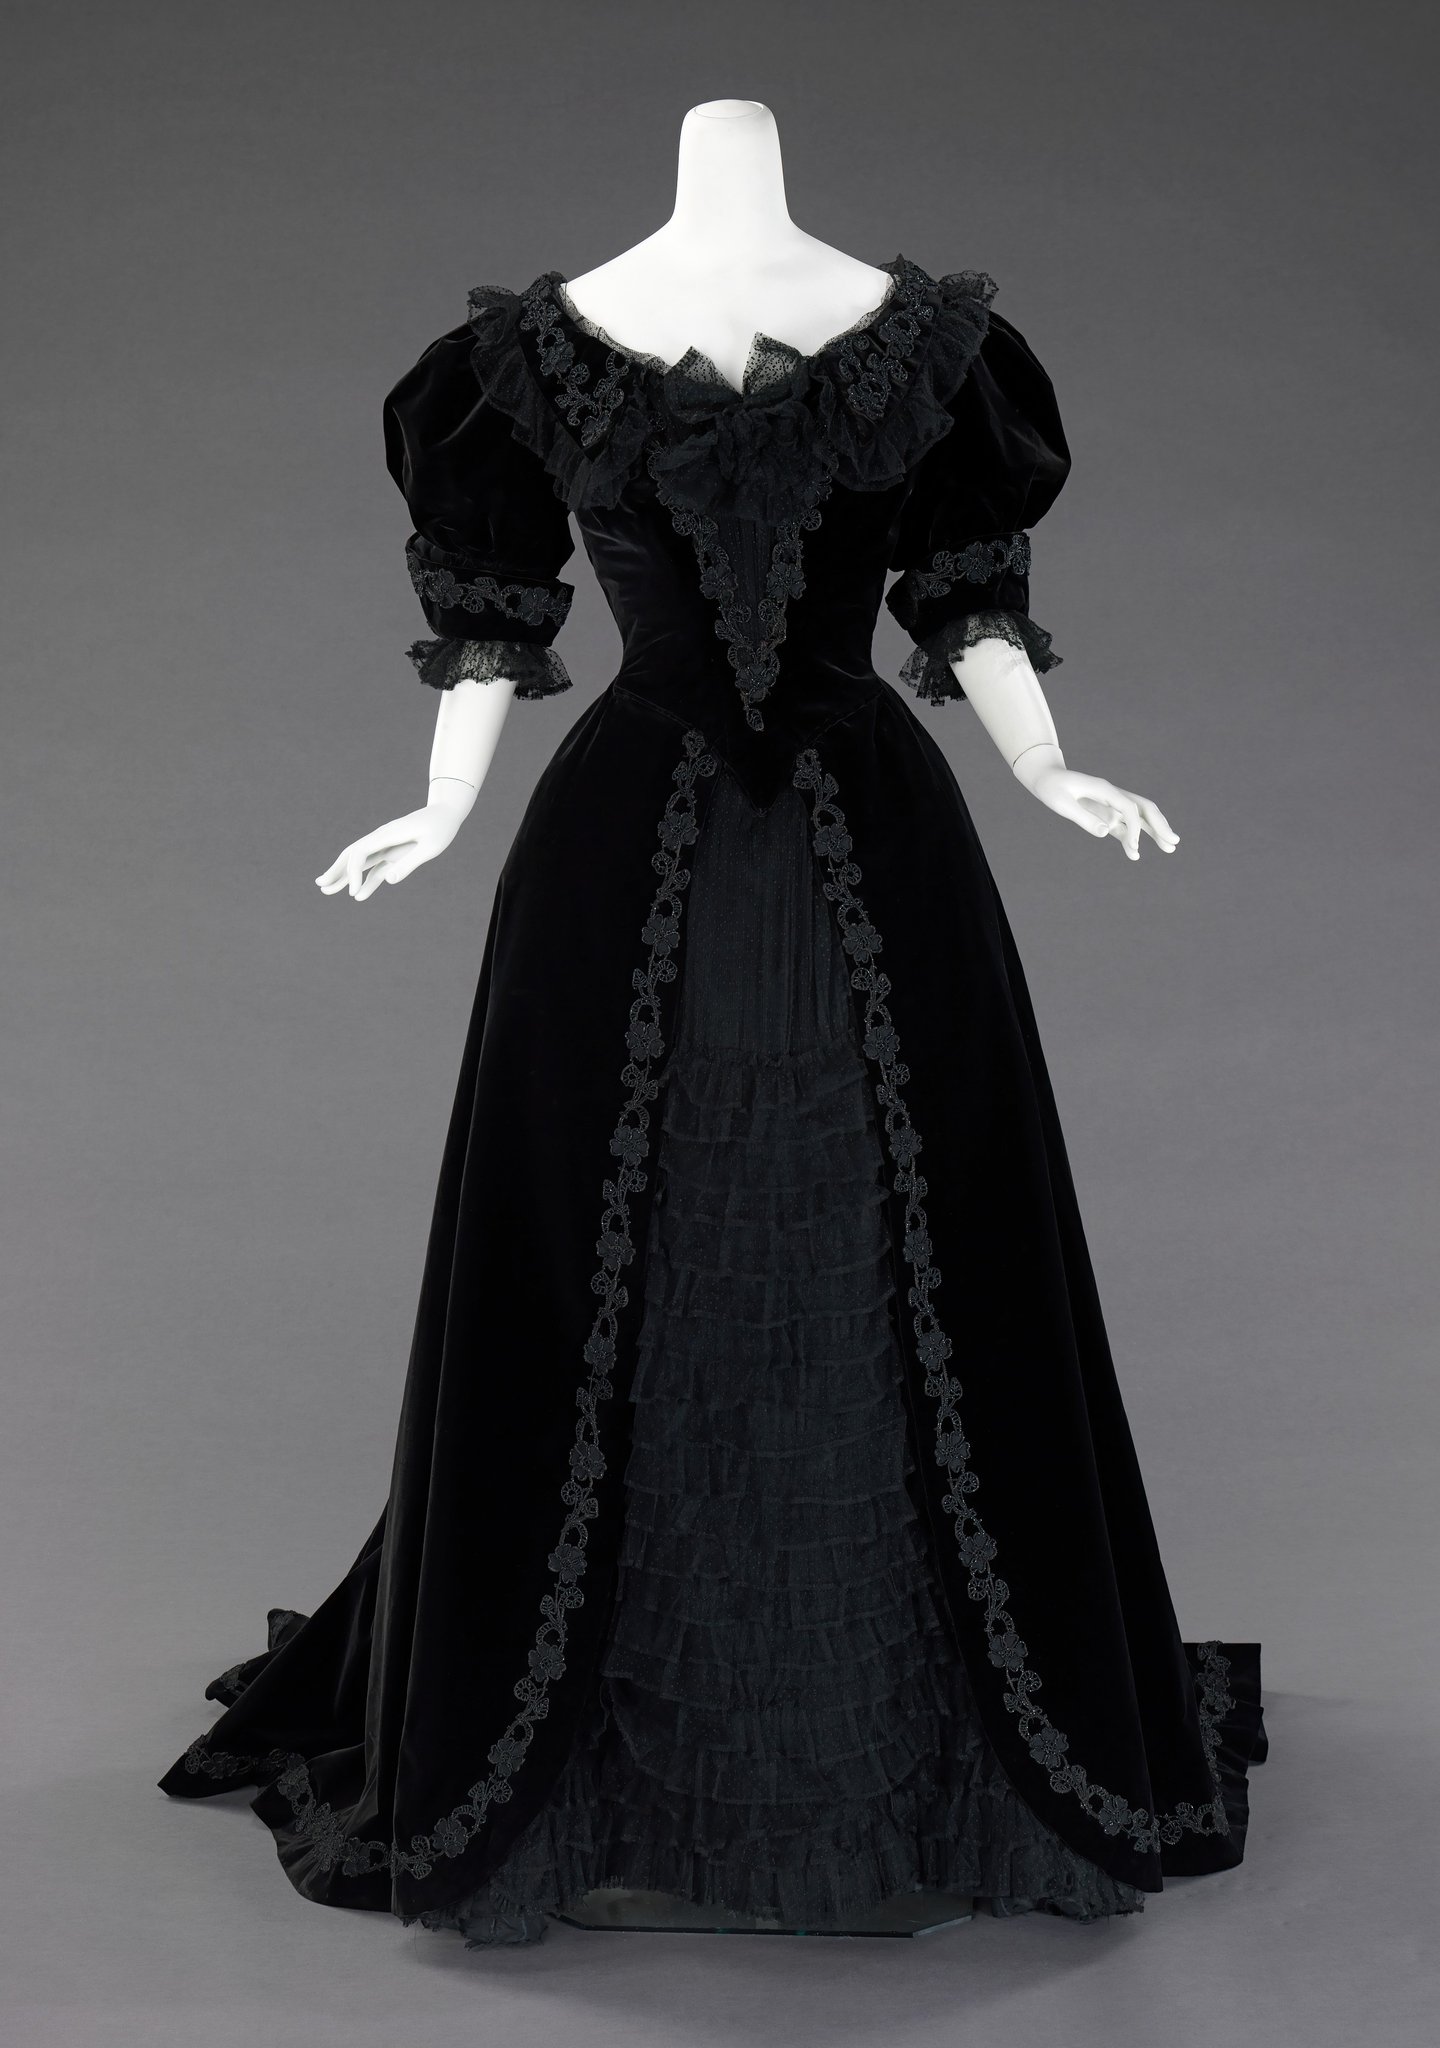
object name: ball gown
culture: french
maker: la religieuse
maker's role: design house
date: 1900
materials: silk